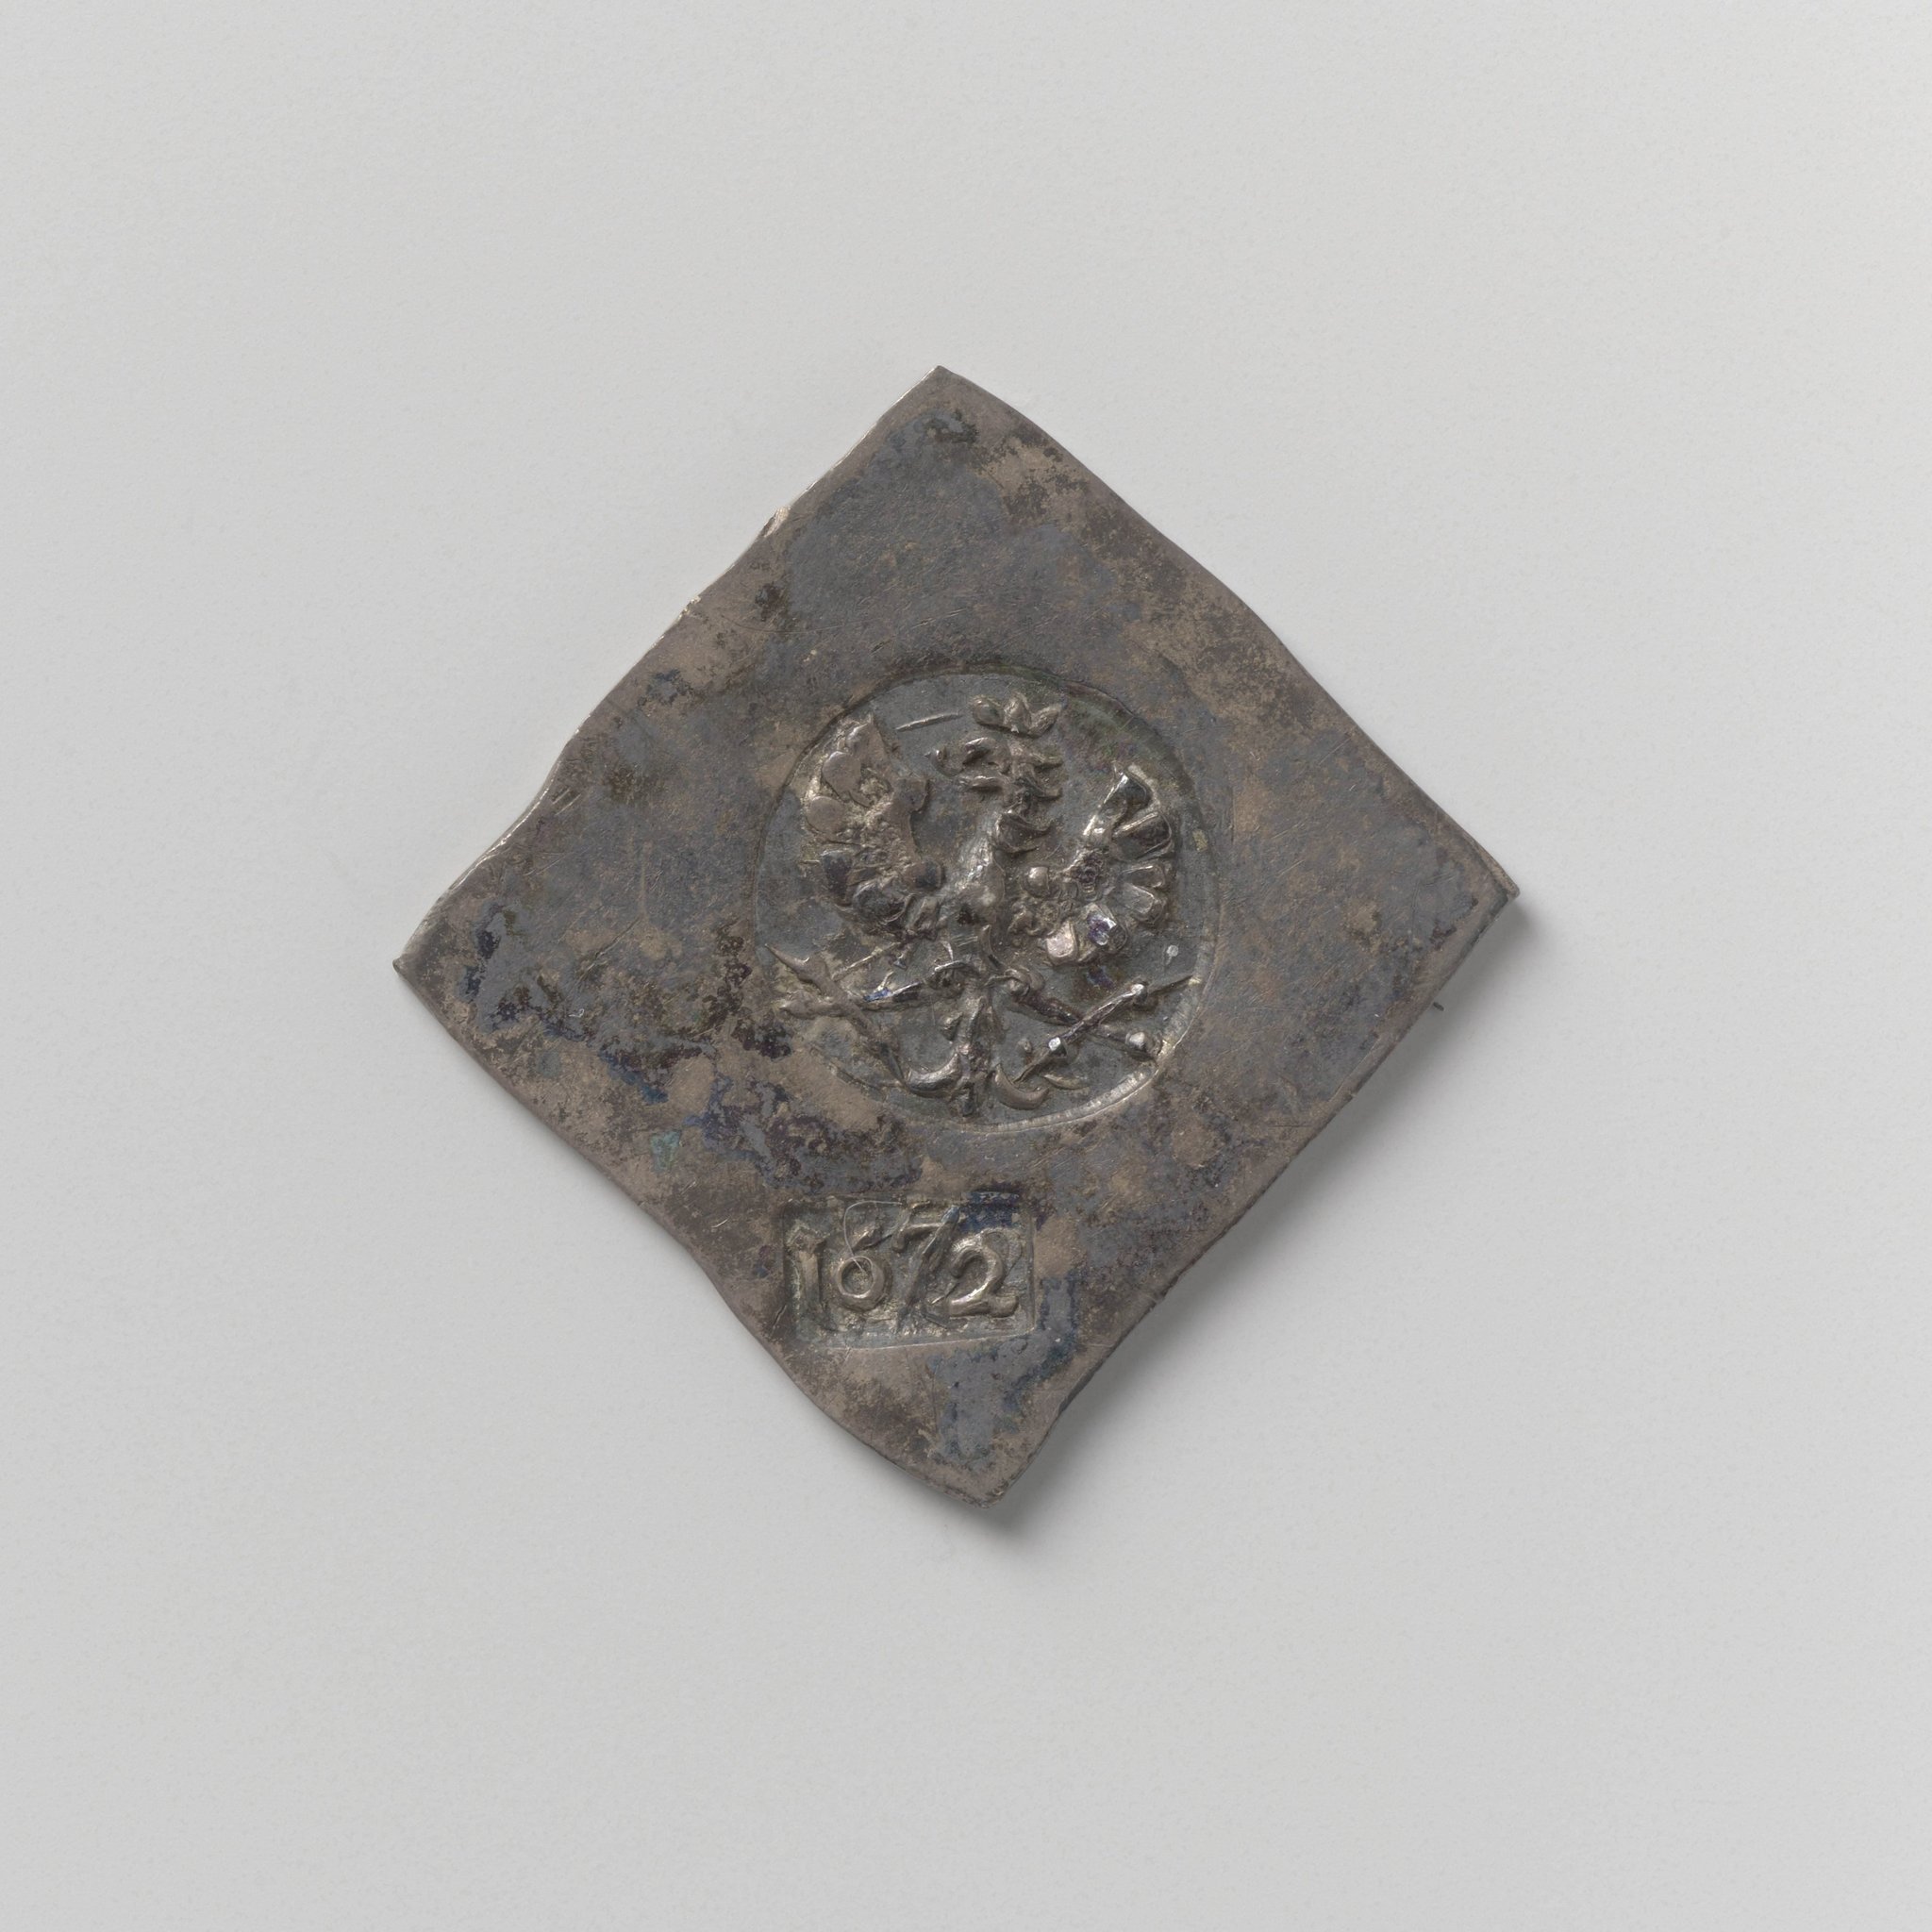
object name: coin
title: achtste daalder, noodmunt uit Deventer, vervaardigd tijdens het beleg uit het raadszilver ter betaling van de oorlogskosten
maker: Anonymous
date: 1672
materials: silver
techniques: striking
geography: kampen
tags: deventer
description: Achtste daalder. Eenzijdige, ruitvormige noodmunt. Voorzijde: twee stempels: grote, ronde stempel: gekroonde adelaar; daaronder: rechthoekige stempel met jaartal. Keerzijde: blanco.